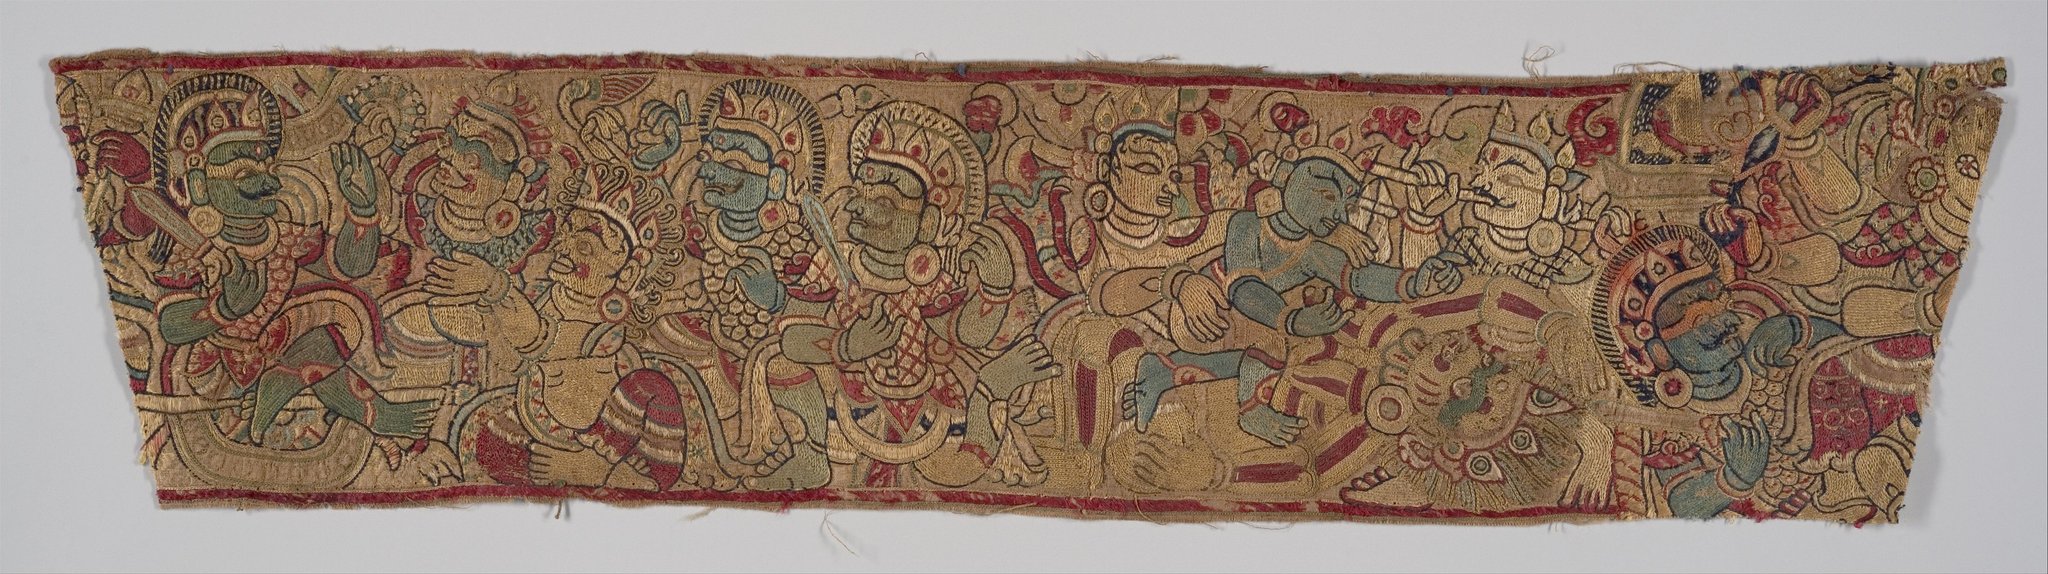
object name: textile panel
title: Textile Panel with Demonic Battle Scenes, Likely from the Devi Mahatmya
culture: nepali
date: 1401-1500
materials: cotton, silk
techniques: embroidery, polish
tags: demons,gods,hinduism